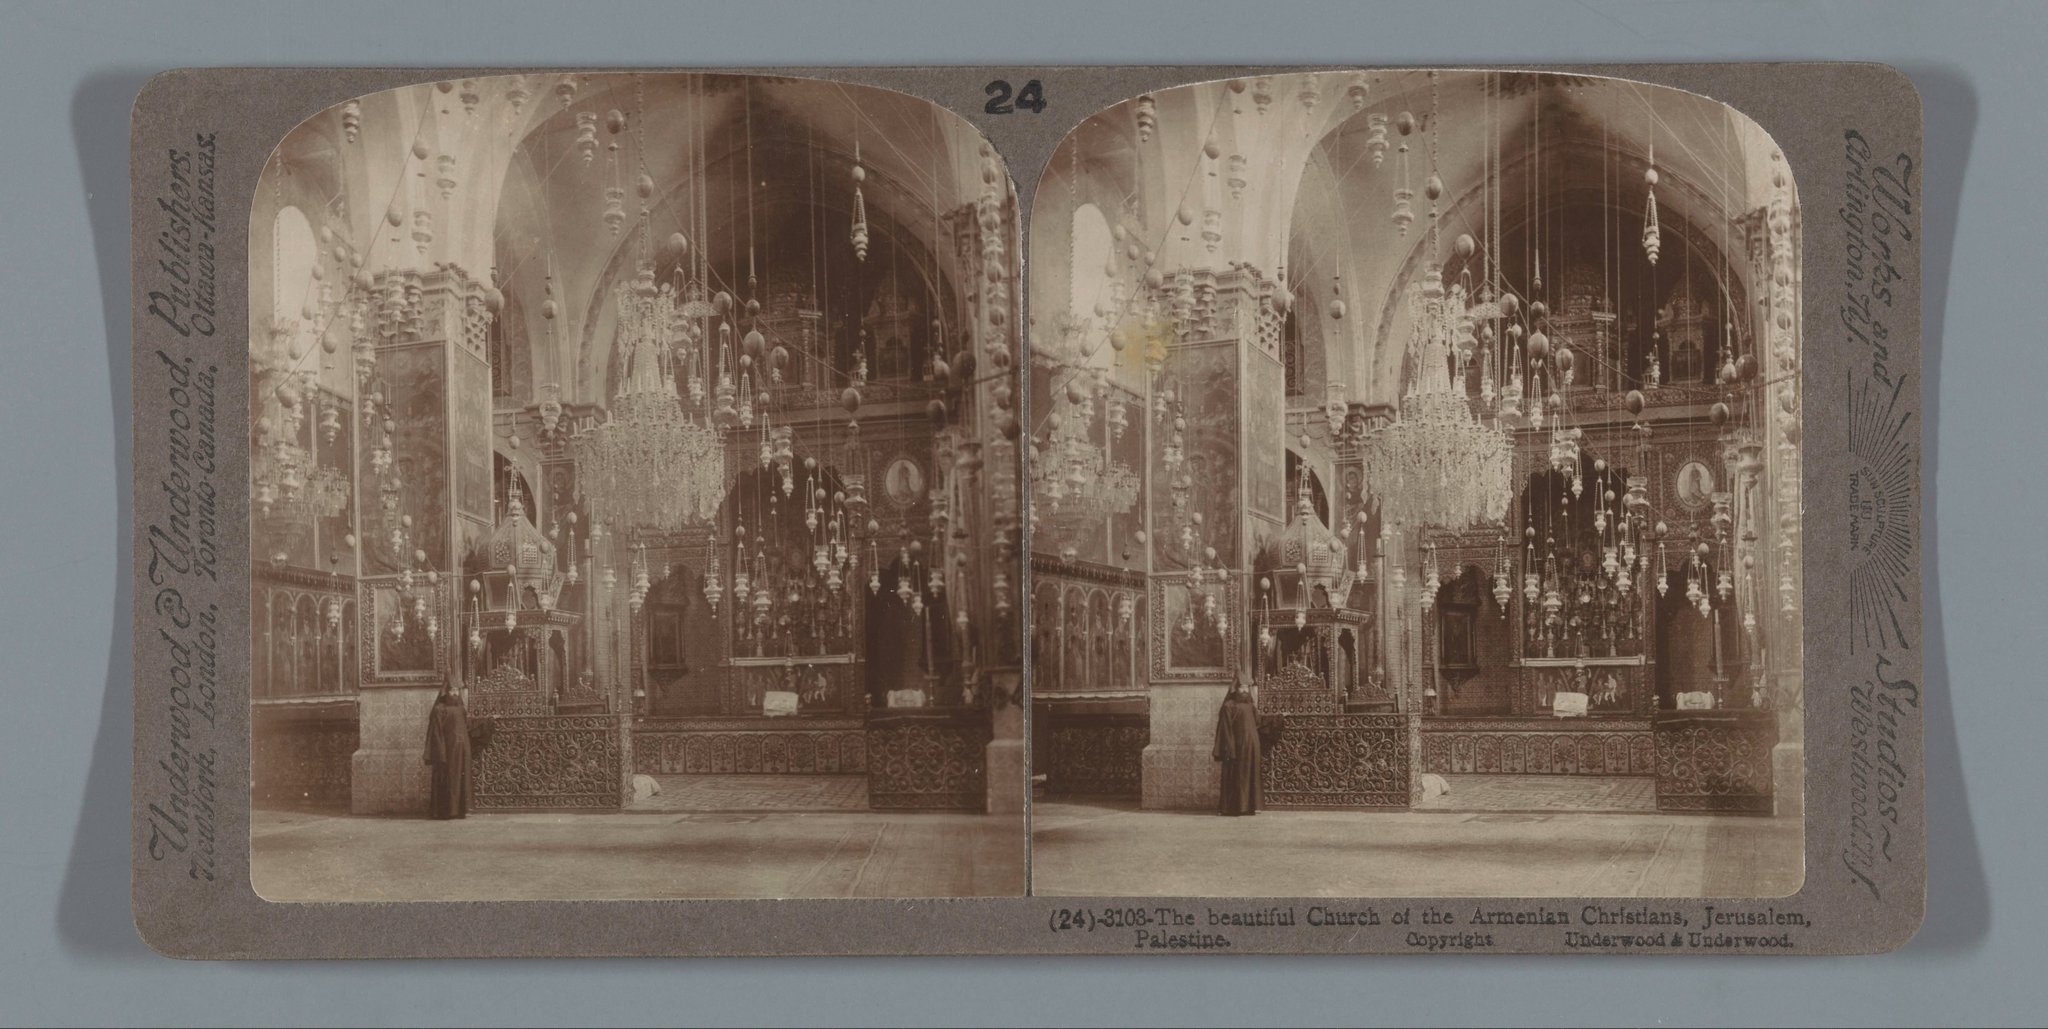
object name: stereograph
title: The beautiful Church of the Armenian Christians, Jerusalem, Palestine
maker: Anonymous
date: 1900-1905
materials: paper, cardboard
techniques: gelatin silver print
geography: new york city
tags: interior of church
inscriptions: copyright notice: ‘Copyright Underwood & Underwood.’, inscription, inscription: ‘Works and Studios ~/ Arlington, N.J. Westwood, N.J.’, number: ‘24’, number: ‘(24)-3103-’